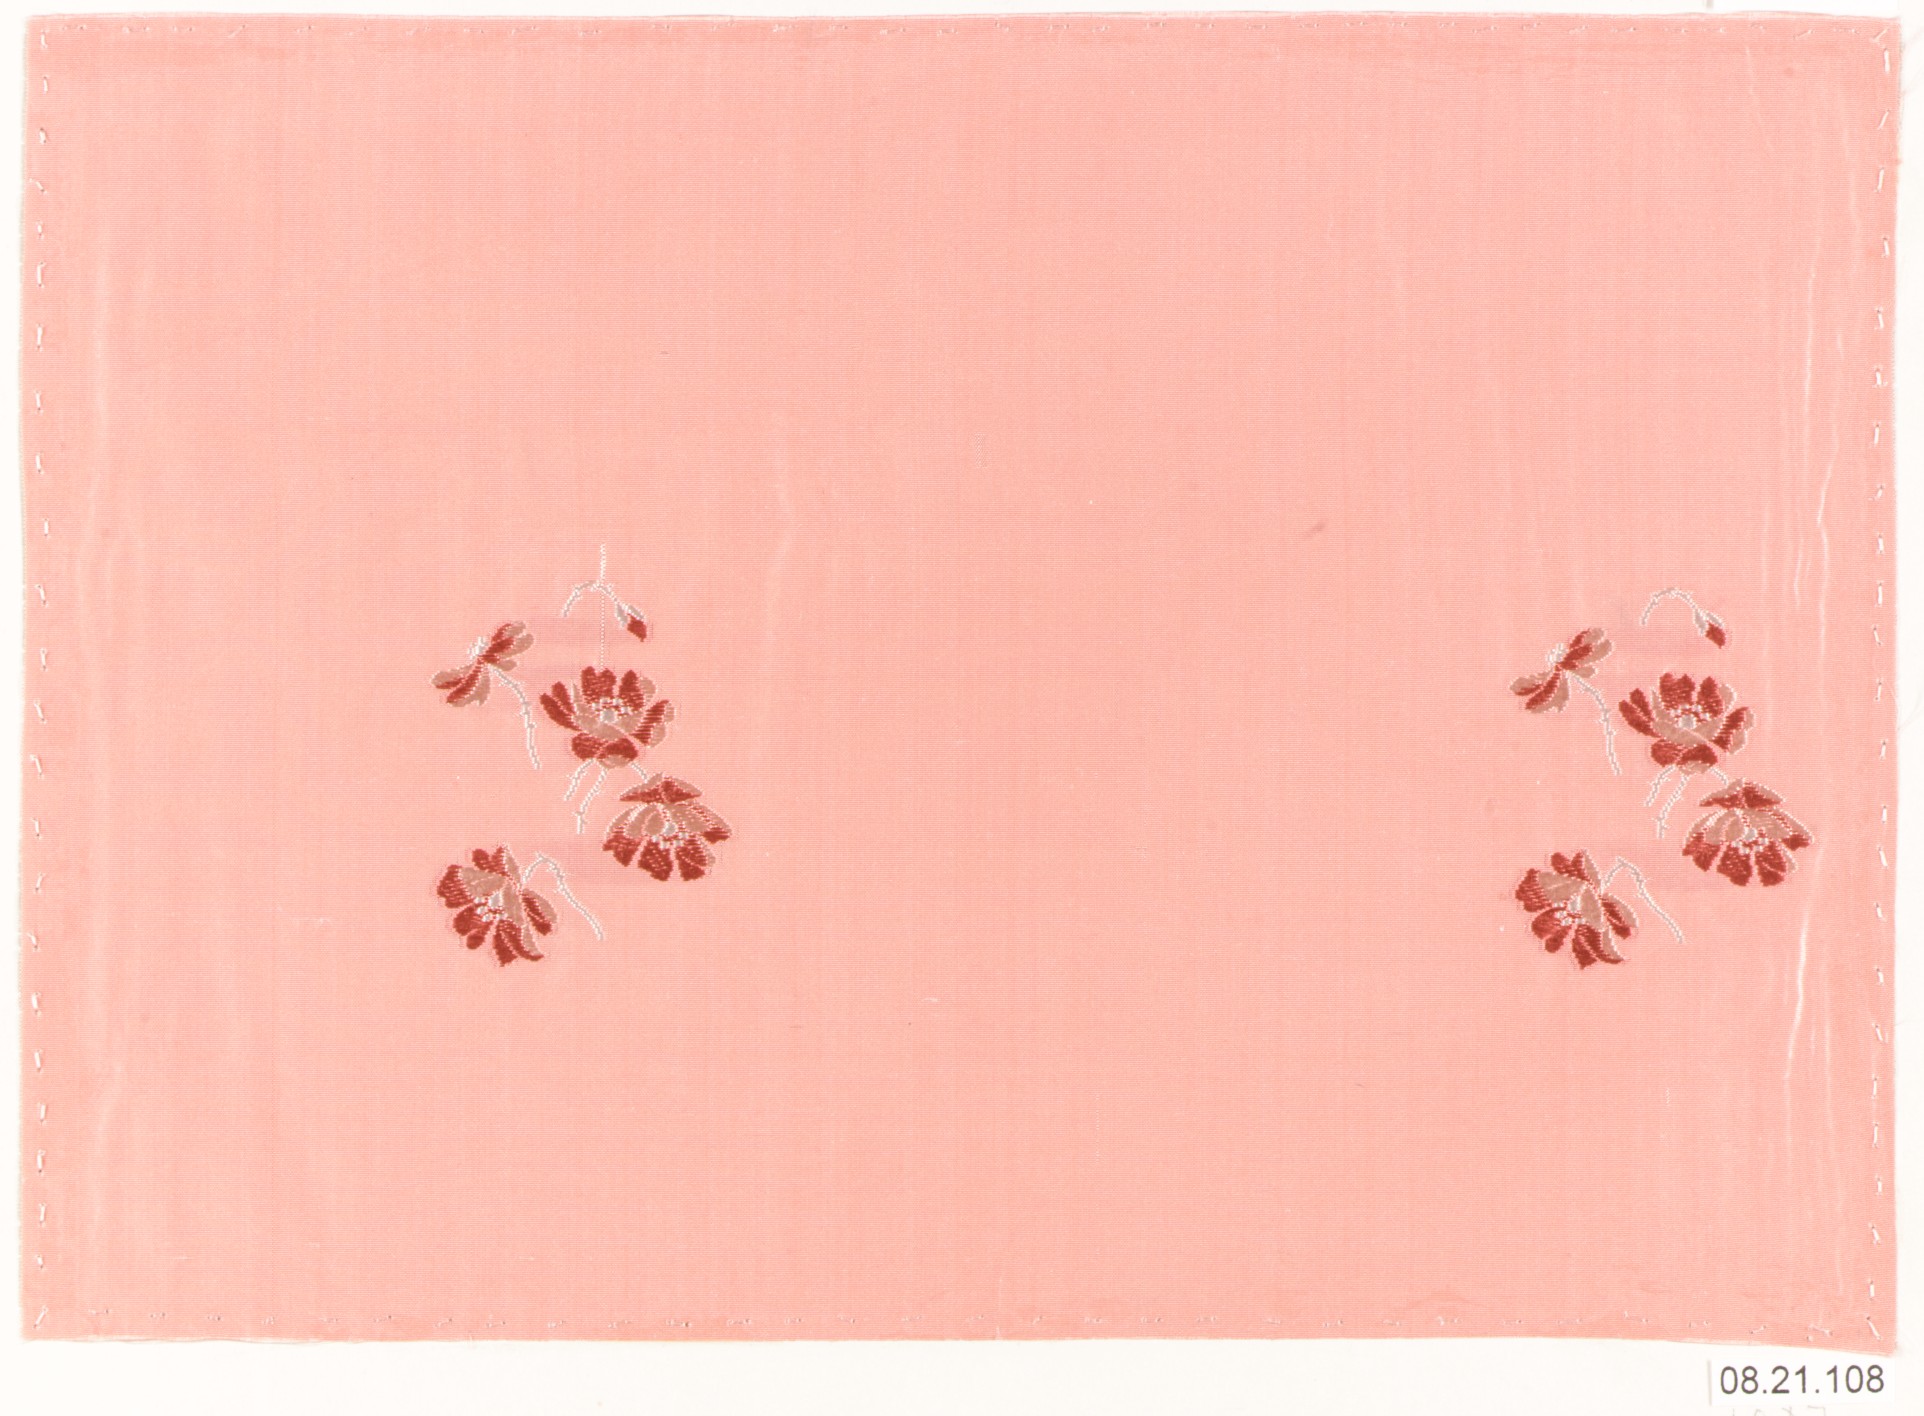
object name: textile sample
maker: Anonymous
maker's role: designer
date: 1900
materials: silk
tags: flowers